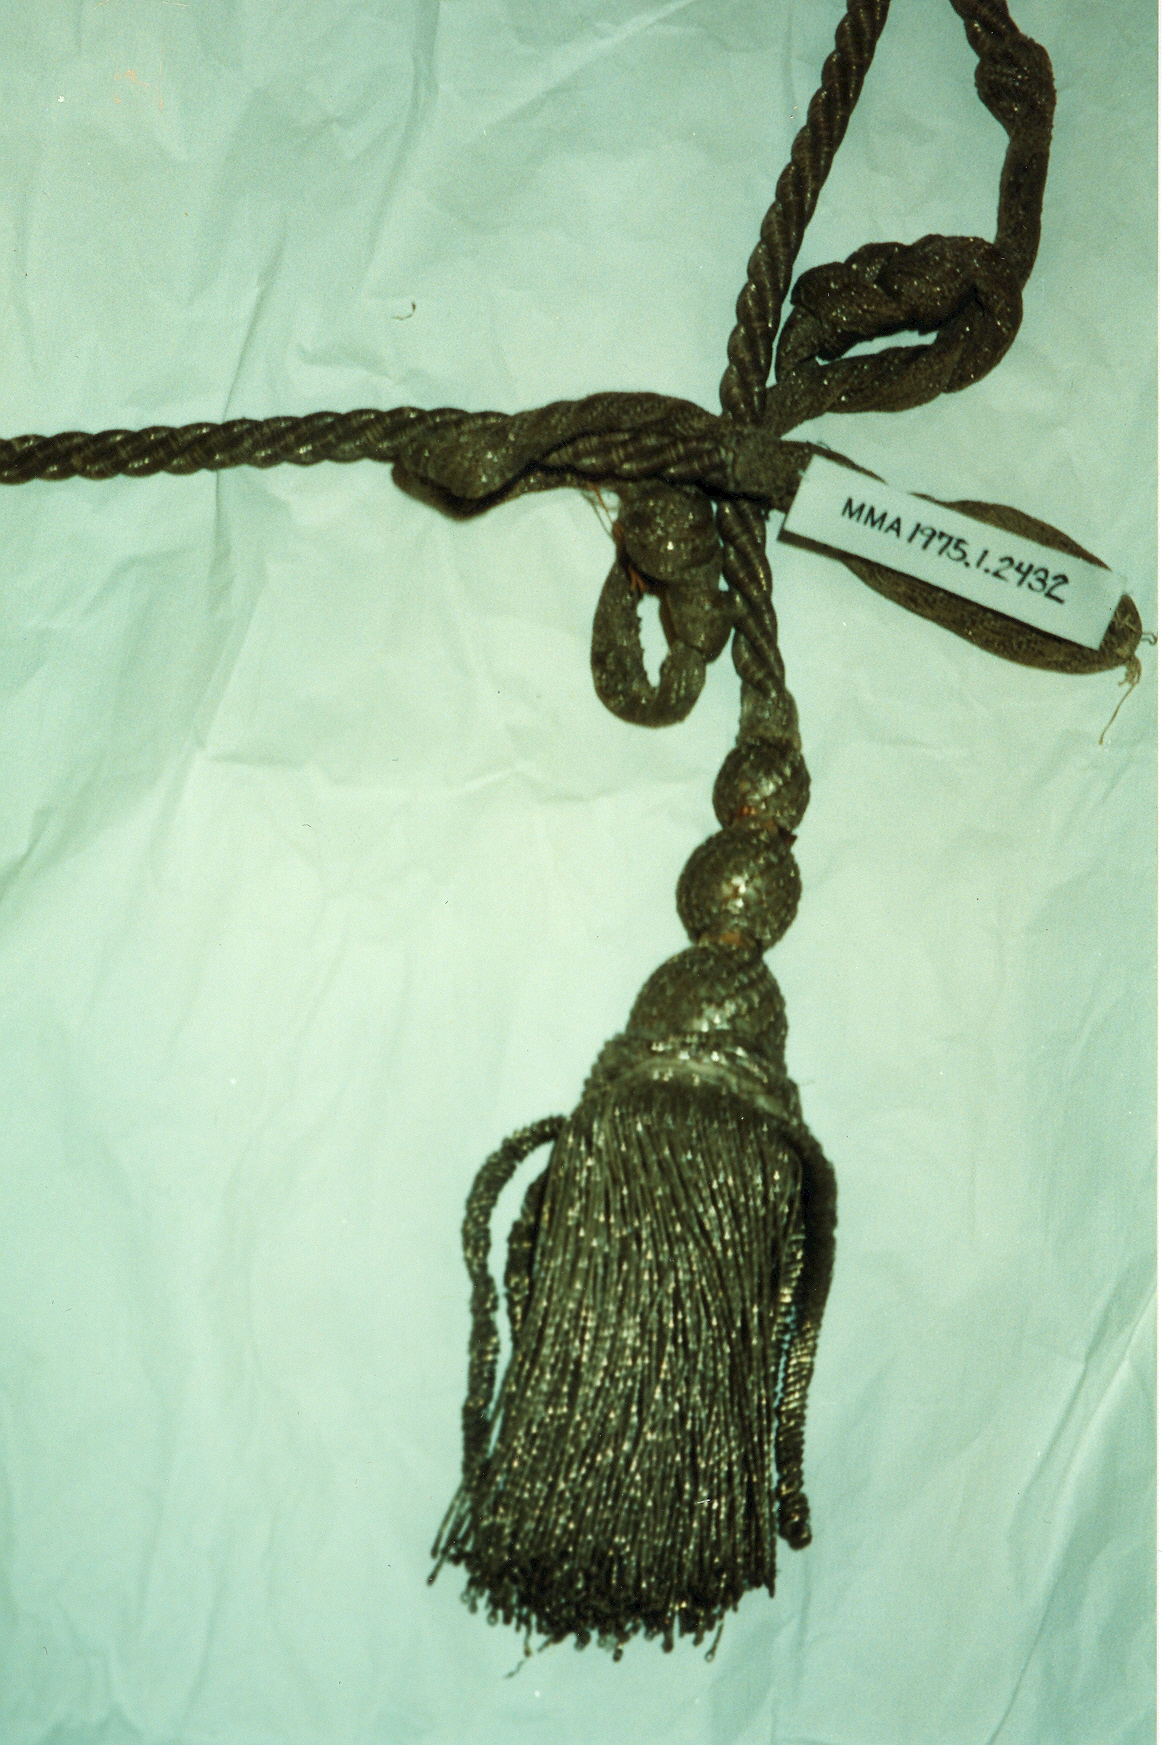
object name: tassel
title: Silver tassel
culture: european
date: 1601-1900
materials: metal, silk